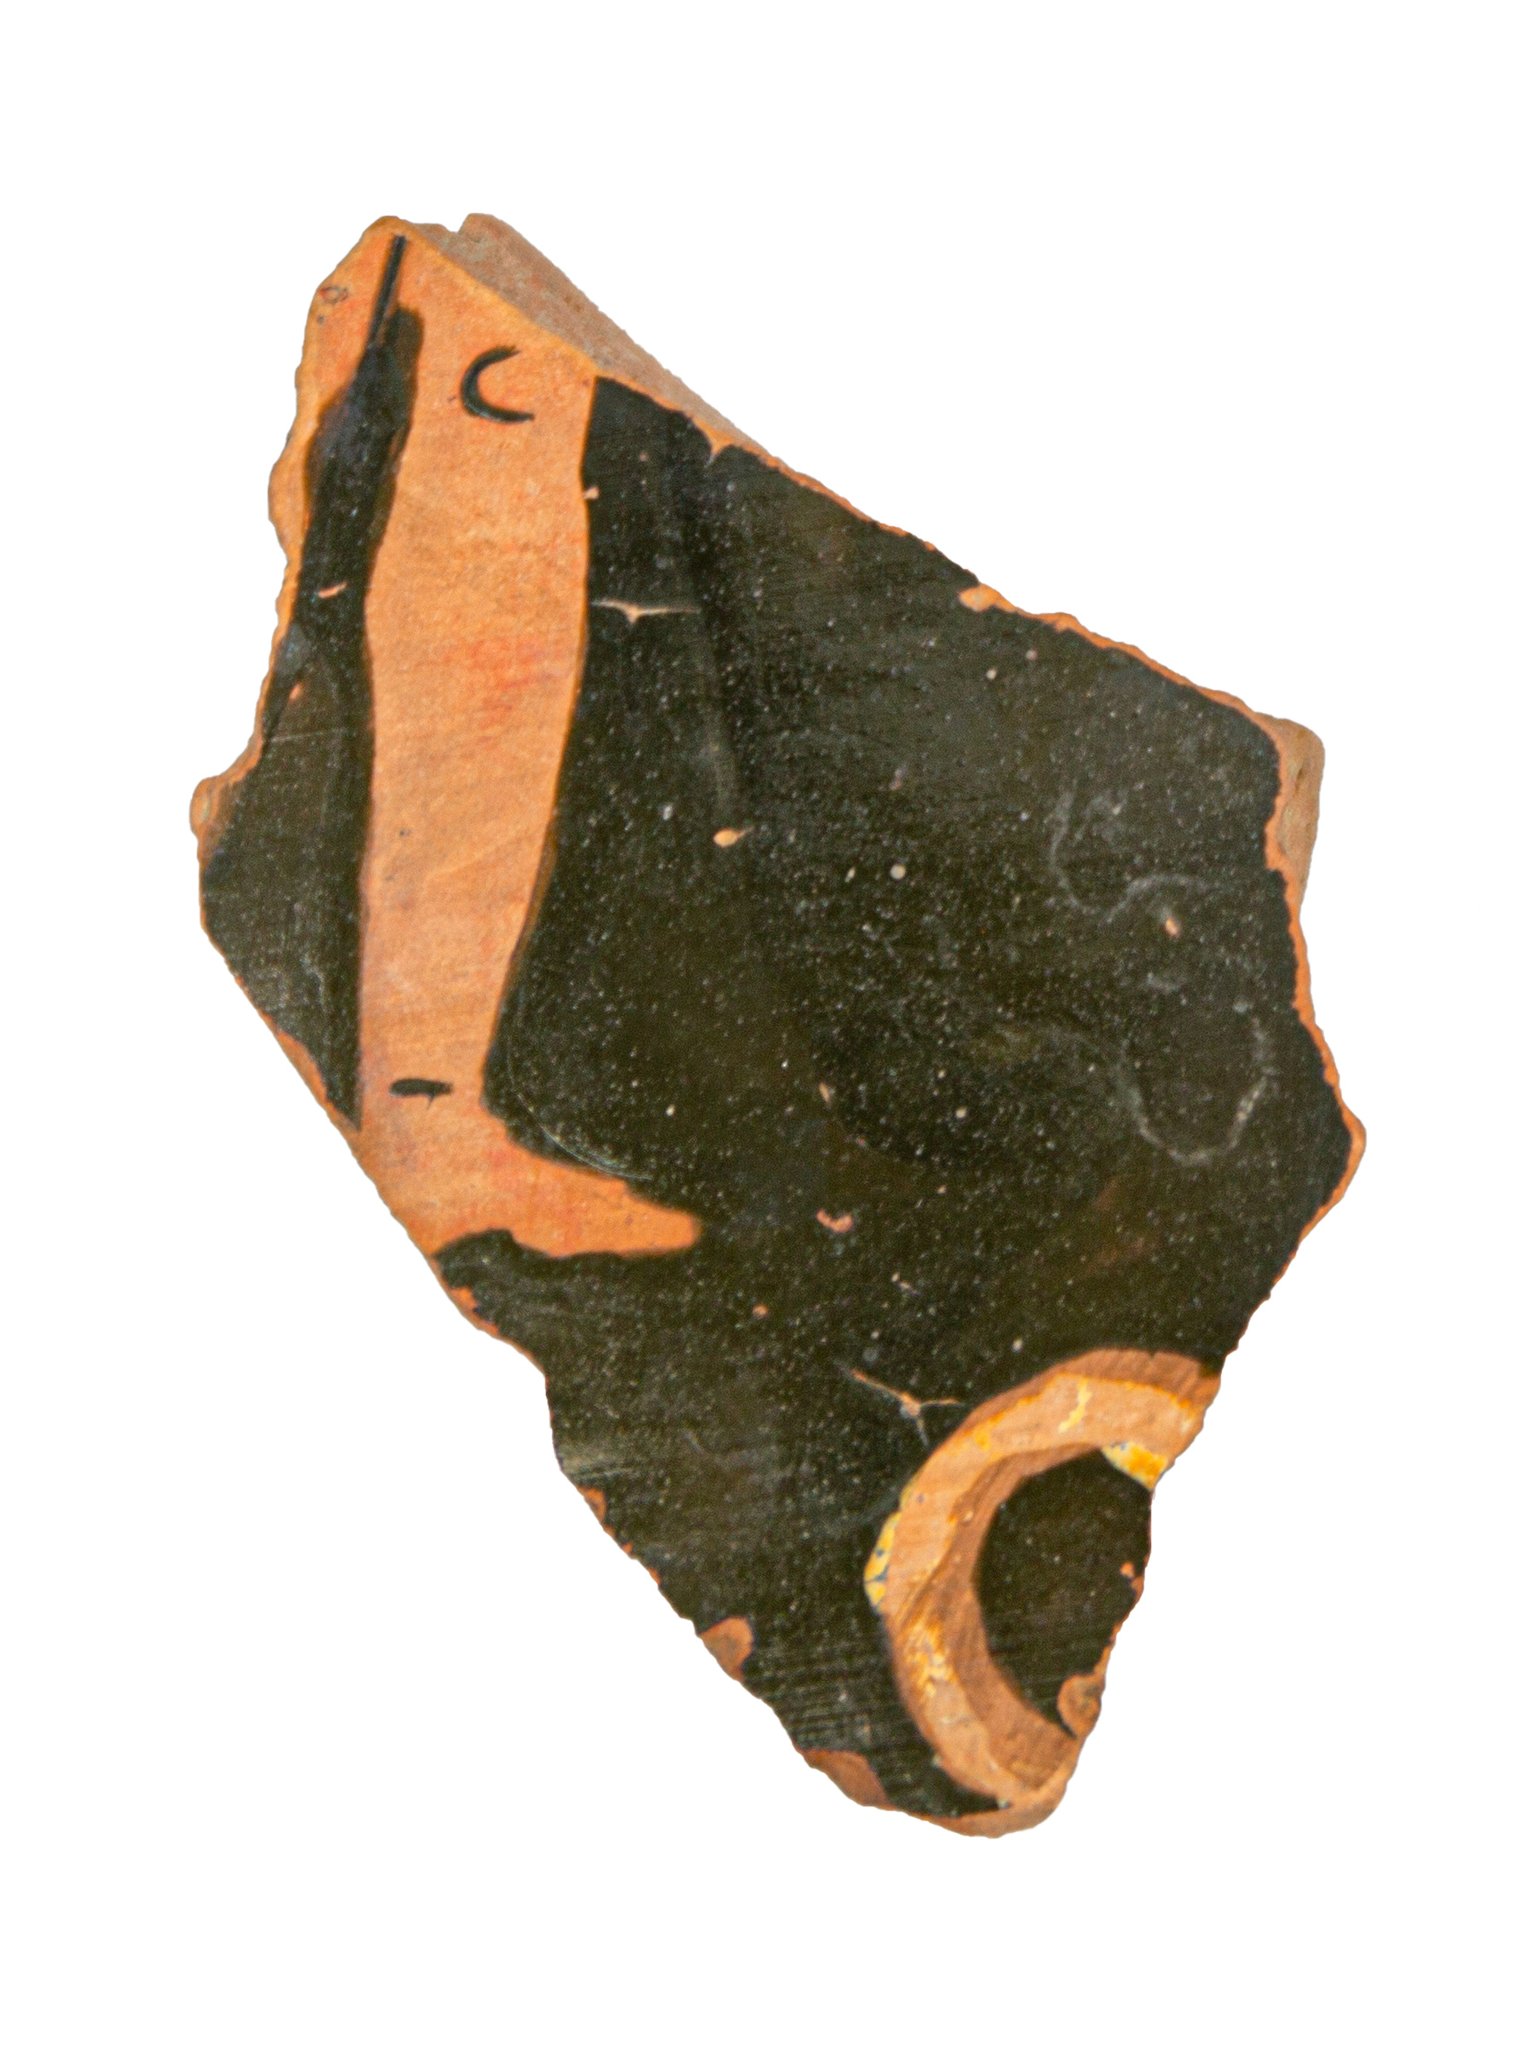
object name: vase fragment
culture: greek, south italian, apulian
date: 400-301 BCE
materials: terracotta